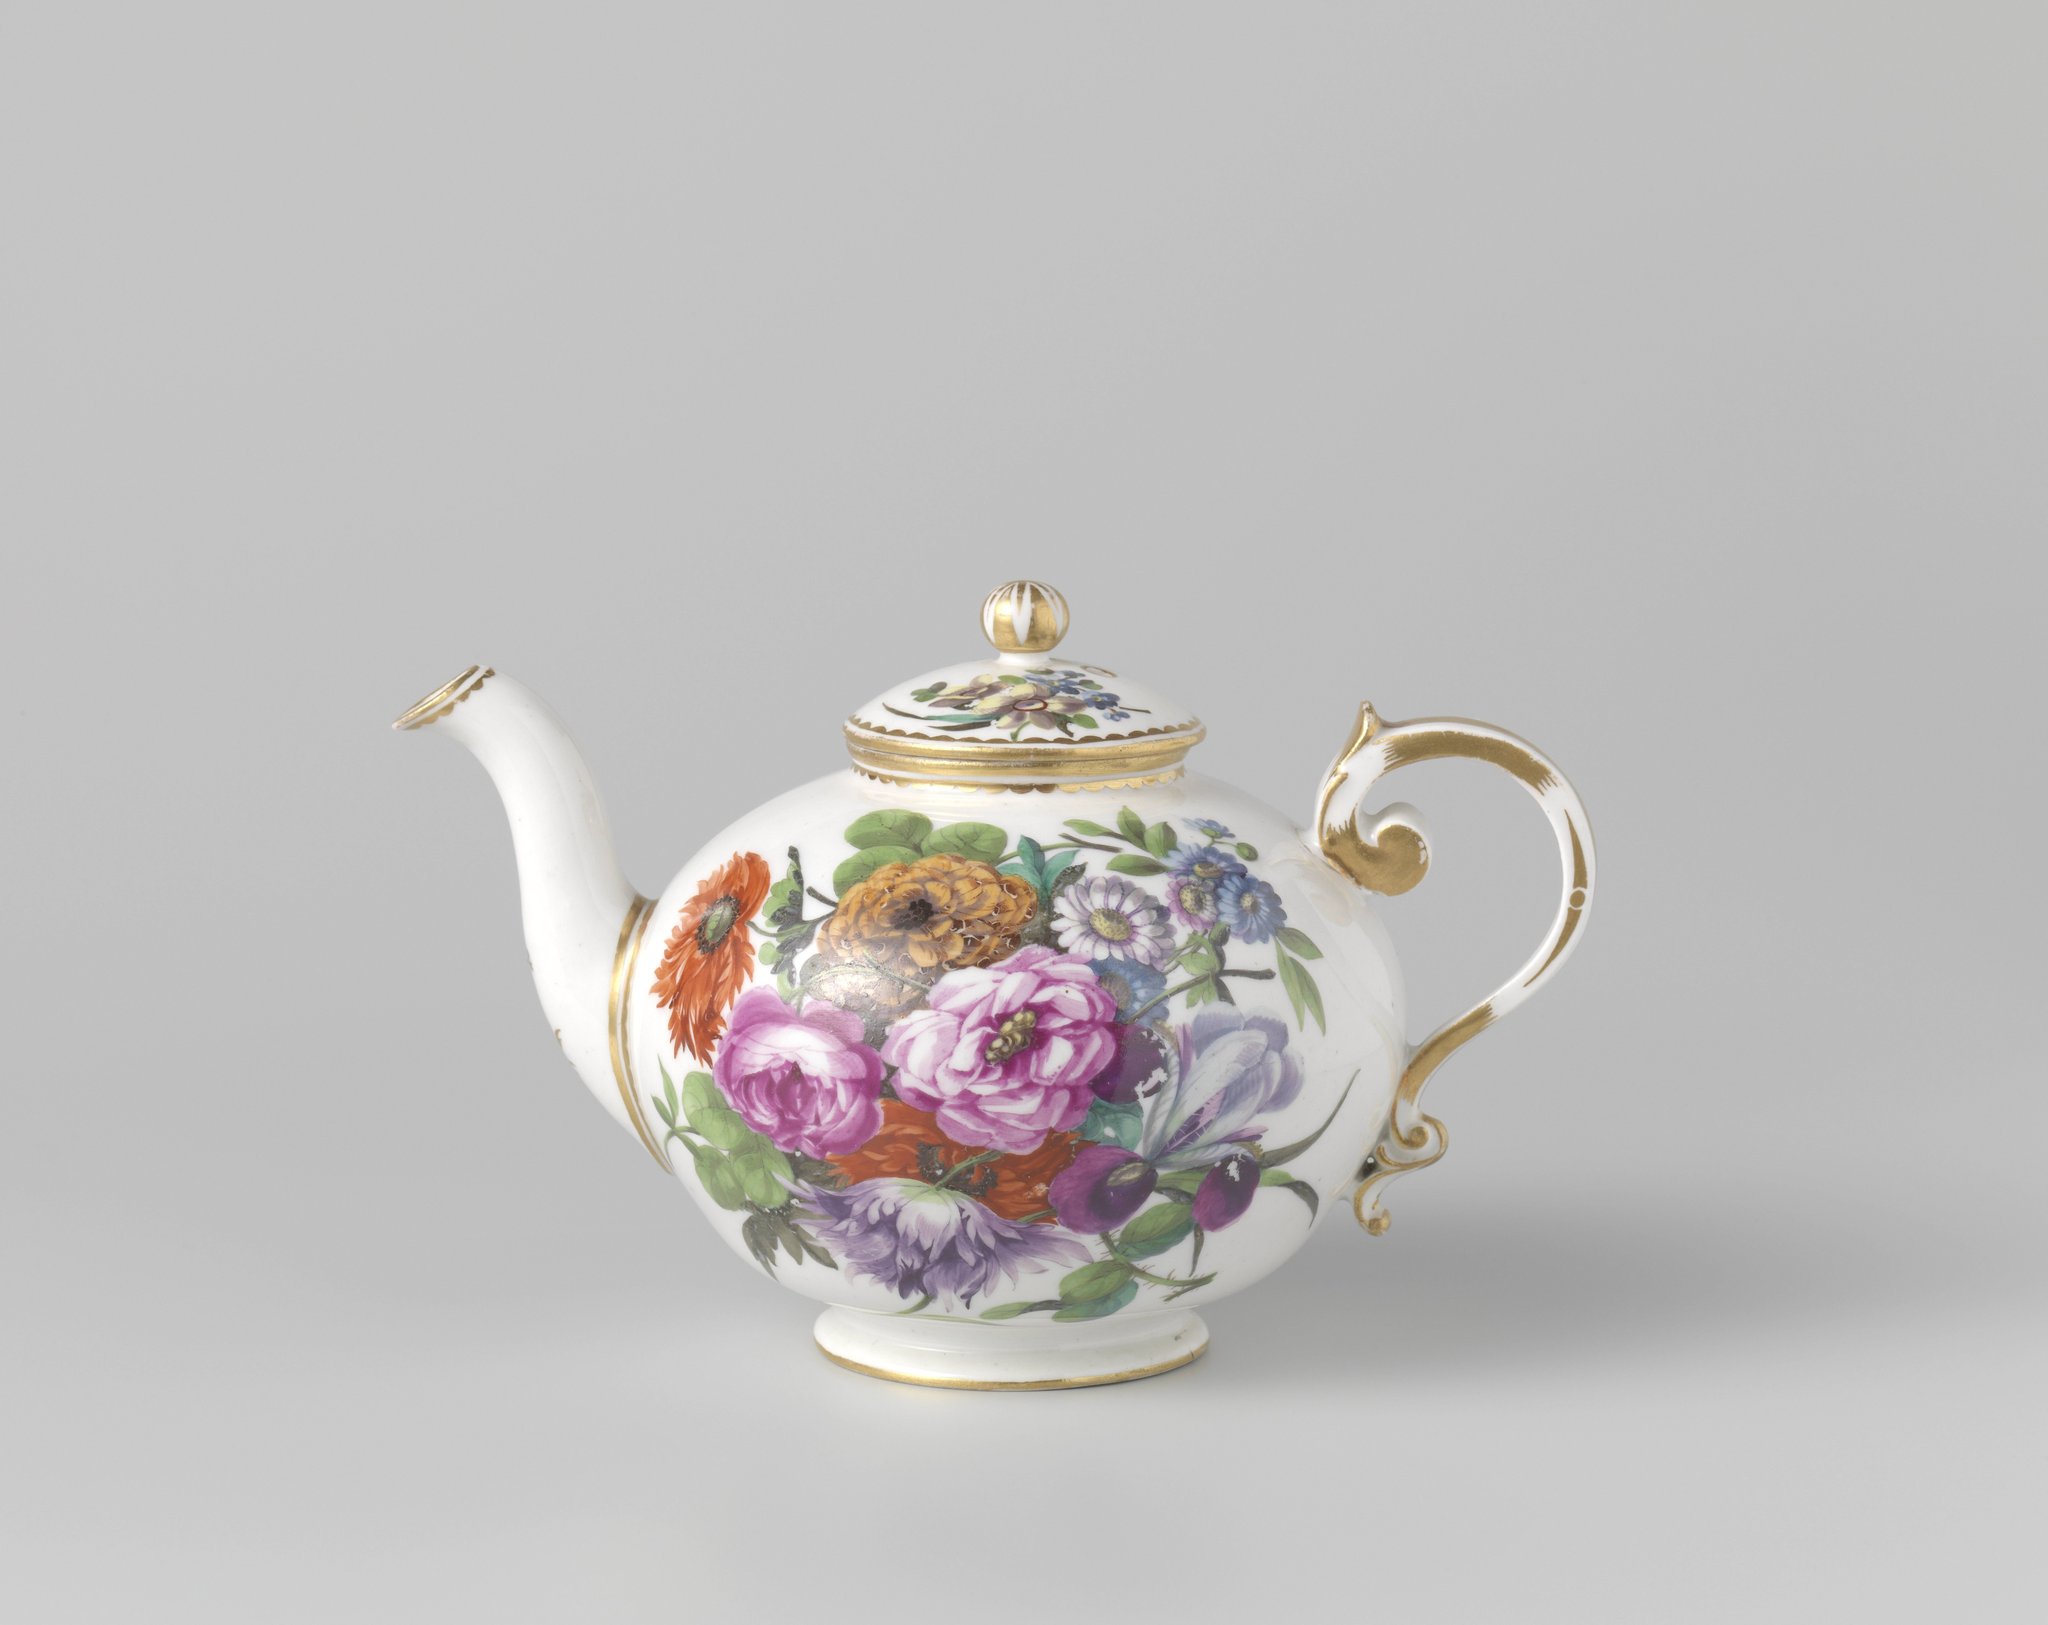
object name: teapot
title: Tea service for two people (tête-à-tête)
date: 1778-1782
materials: porcelain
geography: loosdrecht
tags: cut flowers; nosegay, bunch of flowers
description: Manufactuur Oud-Loosdrecht Loosdrecht, c. 1778–1782 hard-paste porcelain